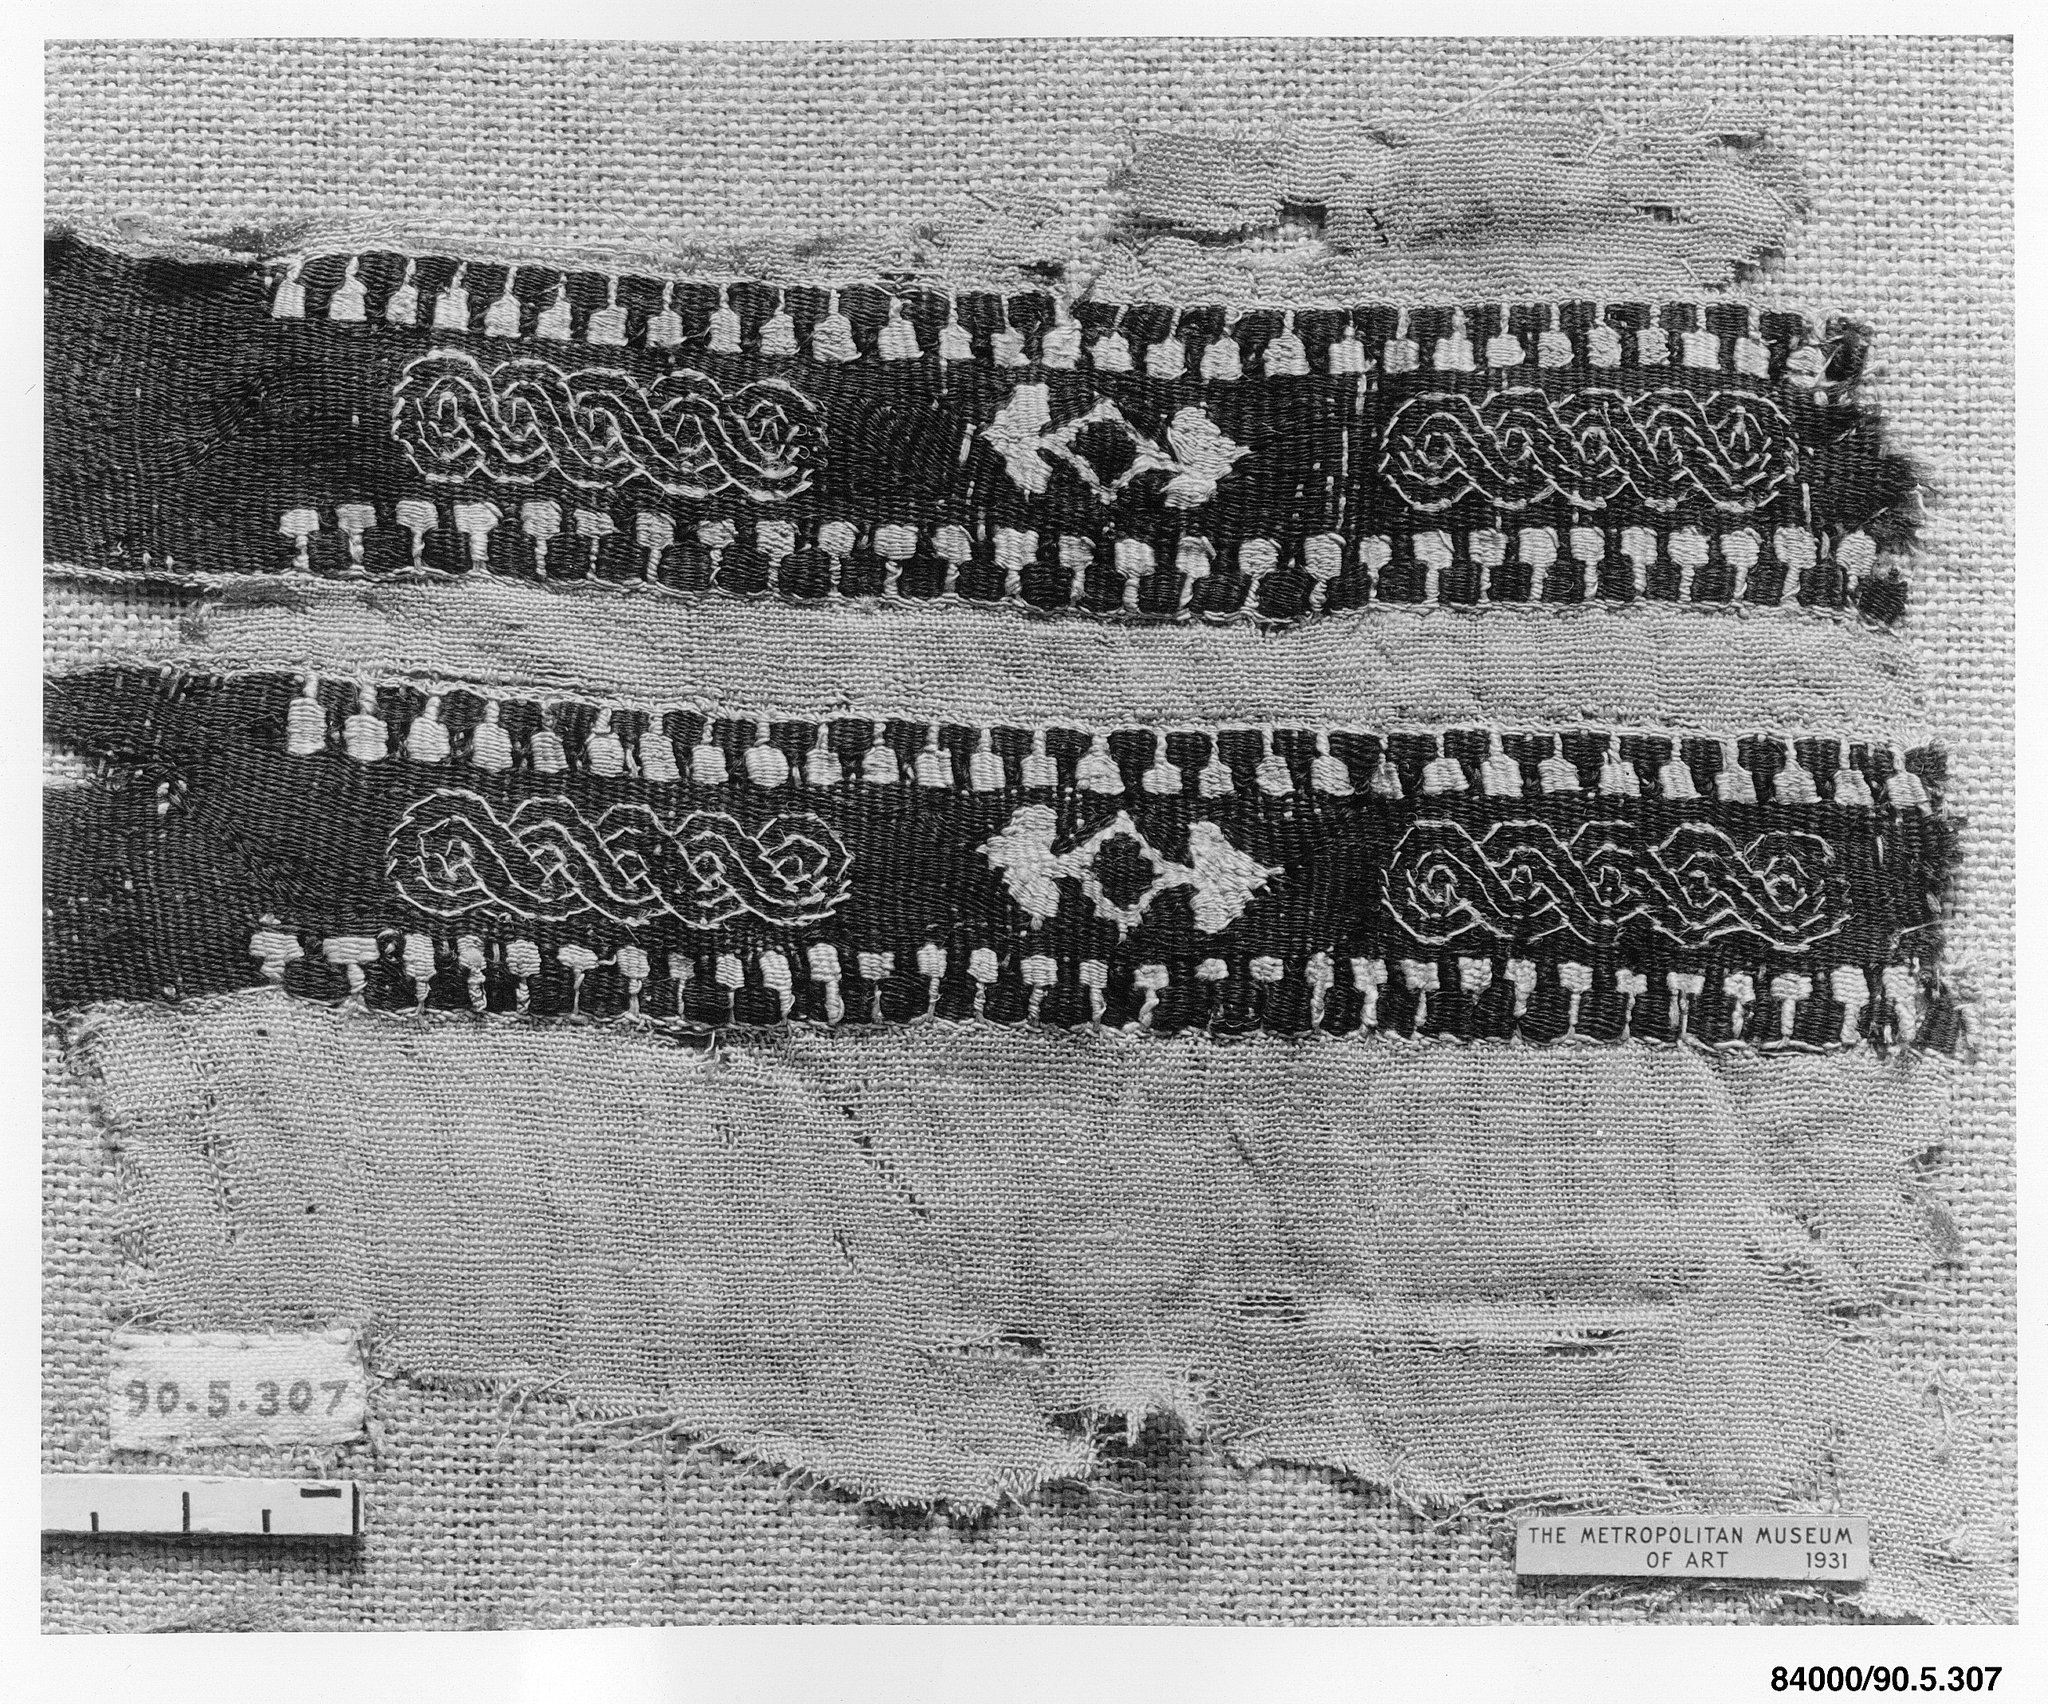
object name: textile fragment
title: Fragment of a Tunic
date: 201-400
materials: linen, wool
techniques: weave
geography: egypt